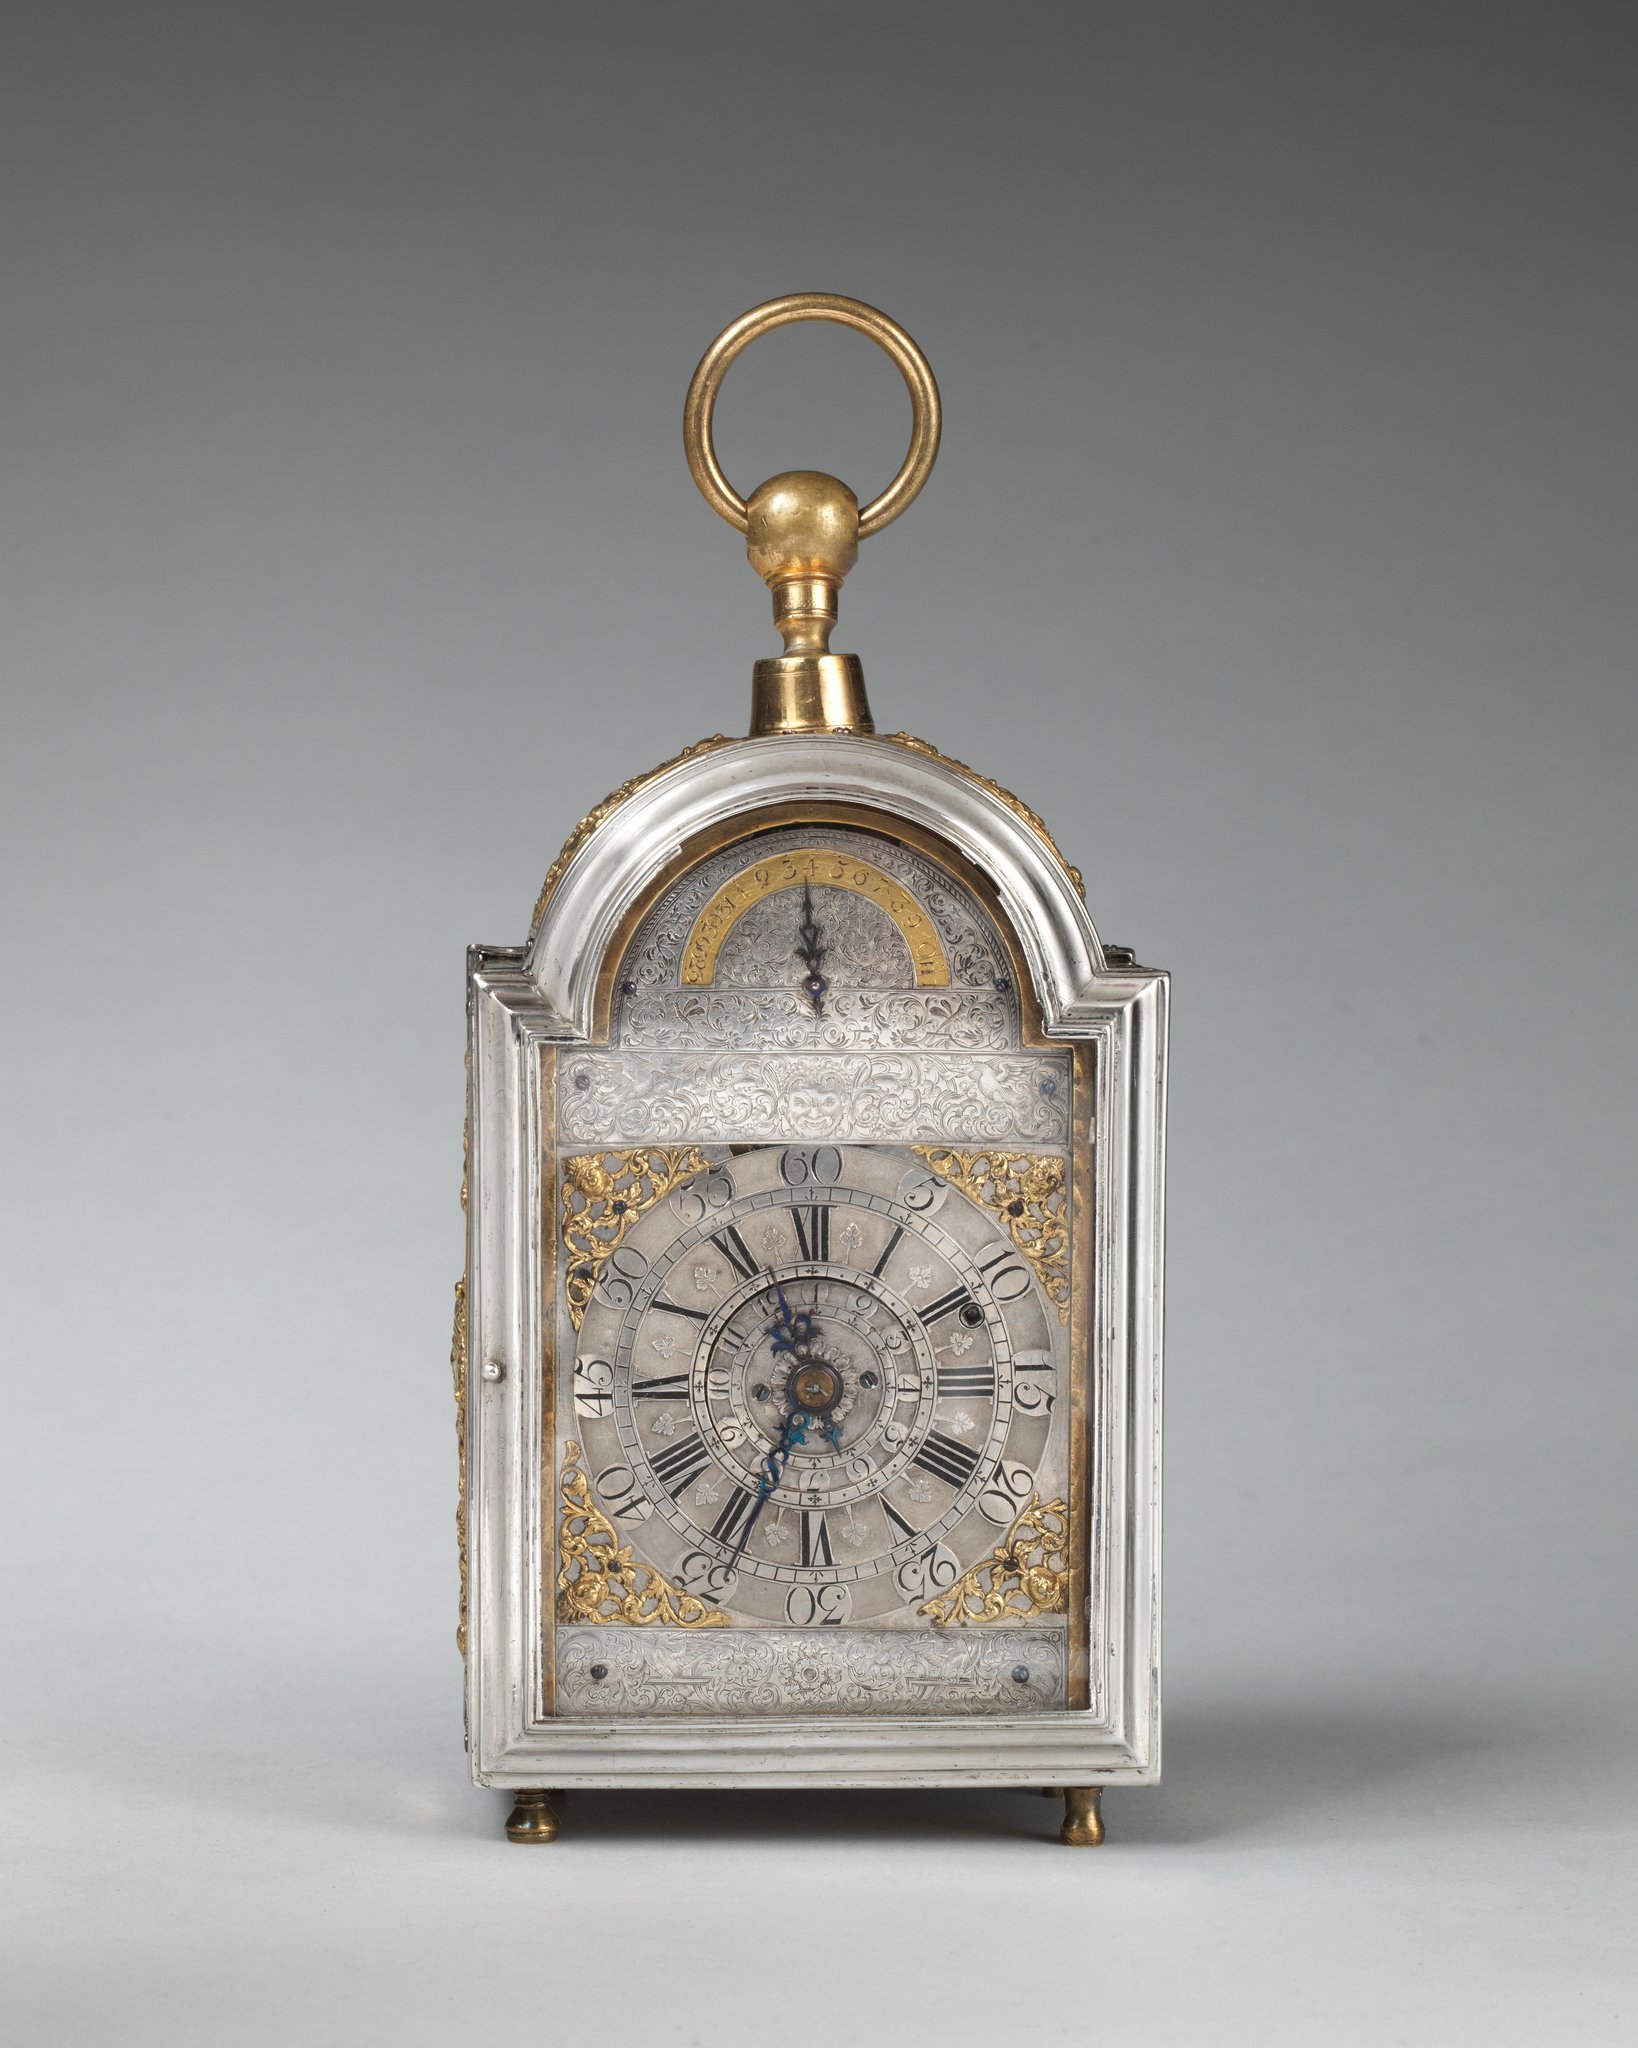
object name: traveling clock with alarm and calendar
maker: joseph paulet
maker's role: maker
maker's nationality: probably french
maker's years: 1687-1716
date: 1700-1710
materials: brass, silver, steel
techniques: gilding